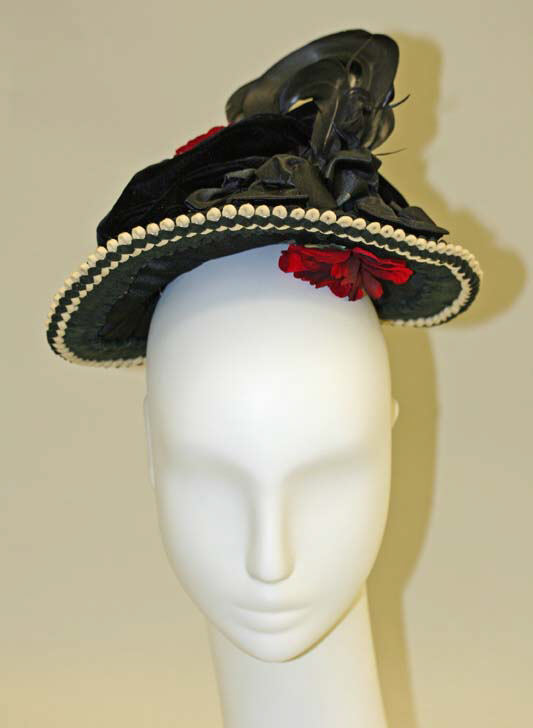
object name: hat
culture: american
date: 1890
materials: feather, silk